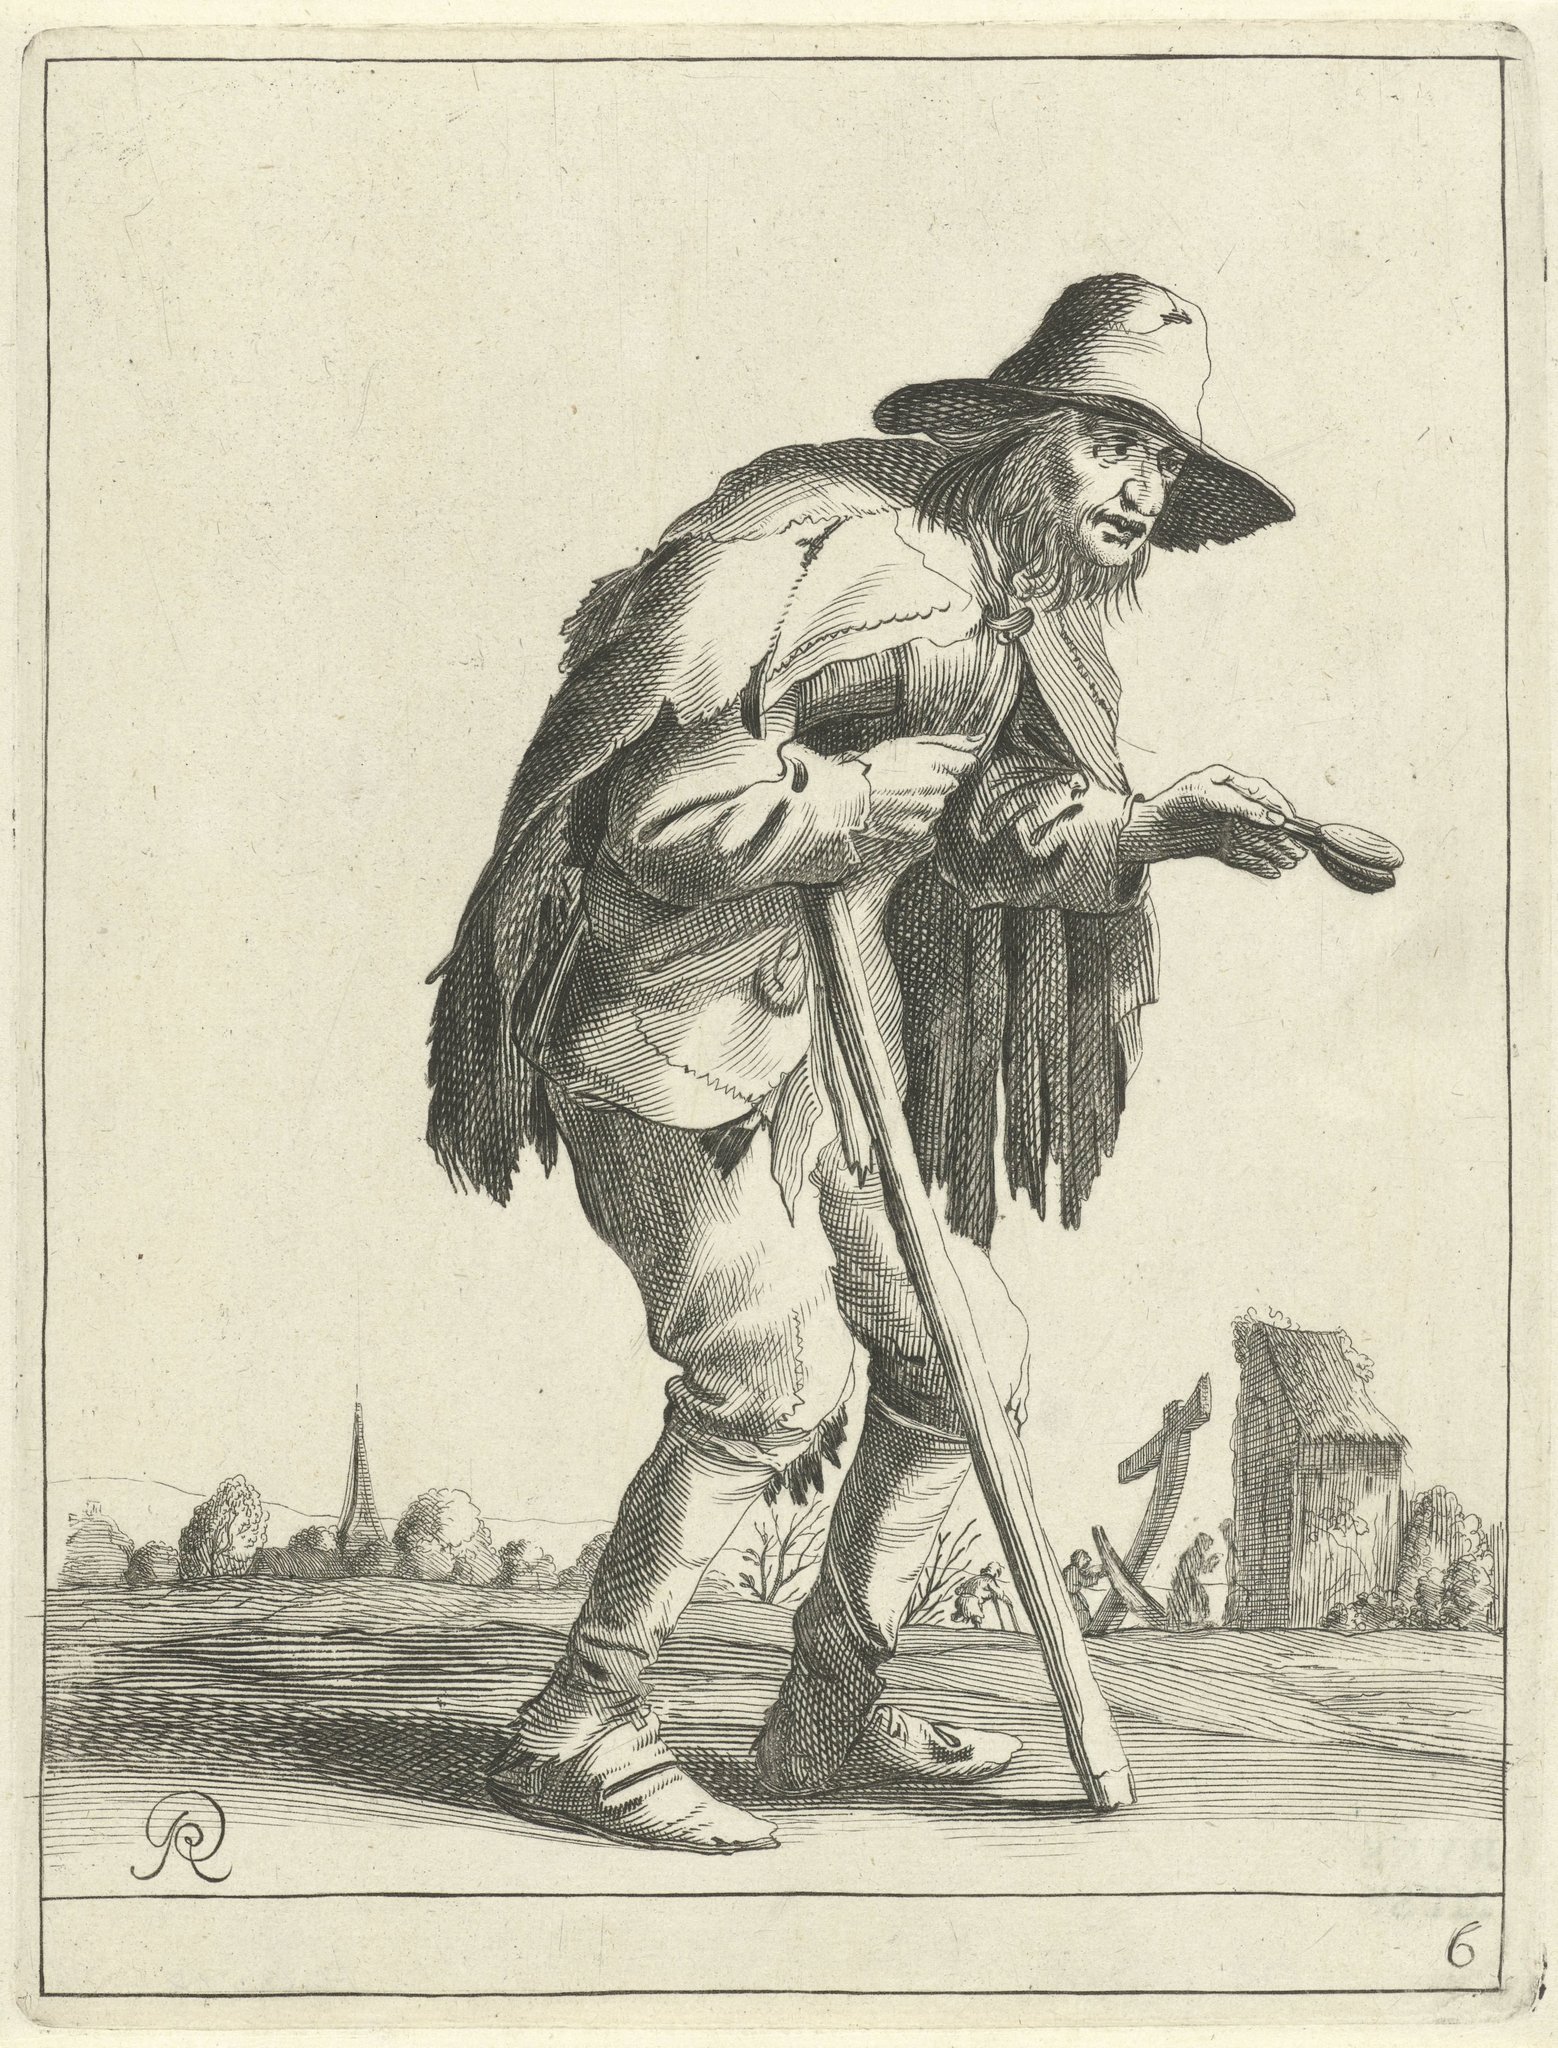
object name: print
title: Melaatse bedelaar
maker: pieter jansz quast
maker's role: draughtsman, painter, print maker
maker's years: 1605-1647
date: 1634-1638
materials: paper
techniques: engraving, etching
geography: the hague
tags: leper's rattle, walking-stick, staff, shed, beggar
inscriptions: collector's mark: Lugt 2165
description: Een bedelaar, met lazarusklep in de hand, loopt steunend op een wandelstok langs een dorp en een schuur. De prent maakt deel uit van een serie van zesentwintig prenten met bedelaars en boeren.